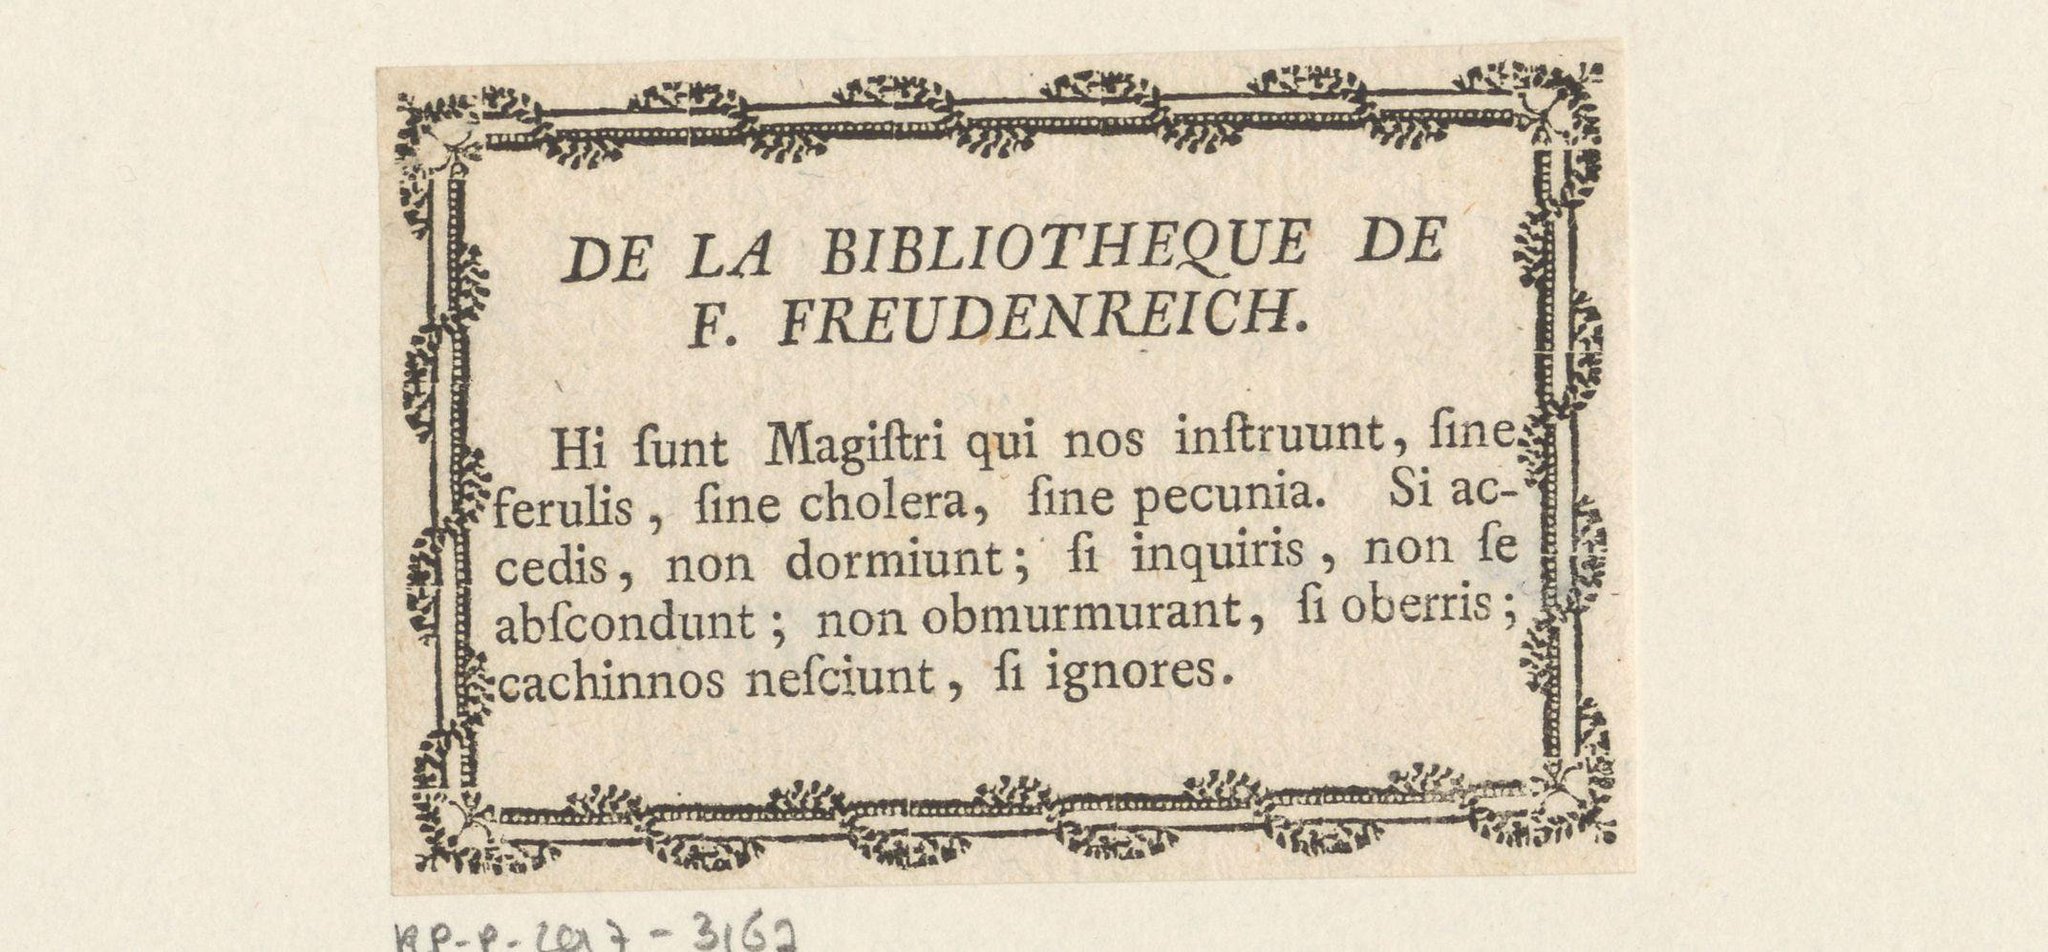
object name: bookplate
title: Ex libris van F. Freudenreich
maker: Anonymous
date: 1750-1850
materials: paper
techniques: letterpress printing, printing block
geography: switzerland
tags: f. freudenreich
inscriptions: inscription: ‘Gerster 793’